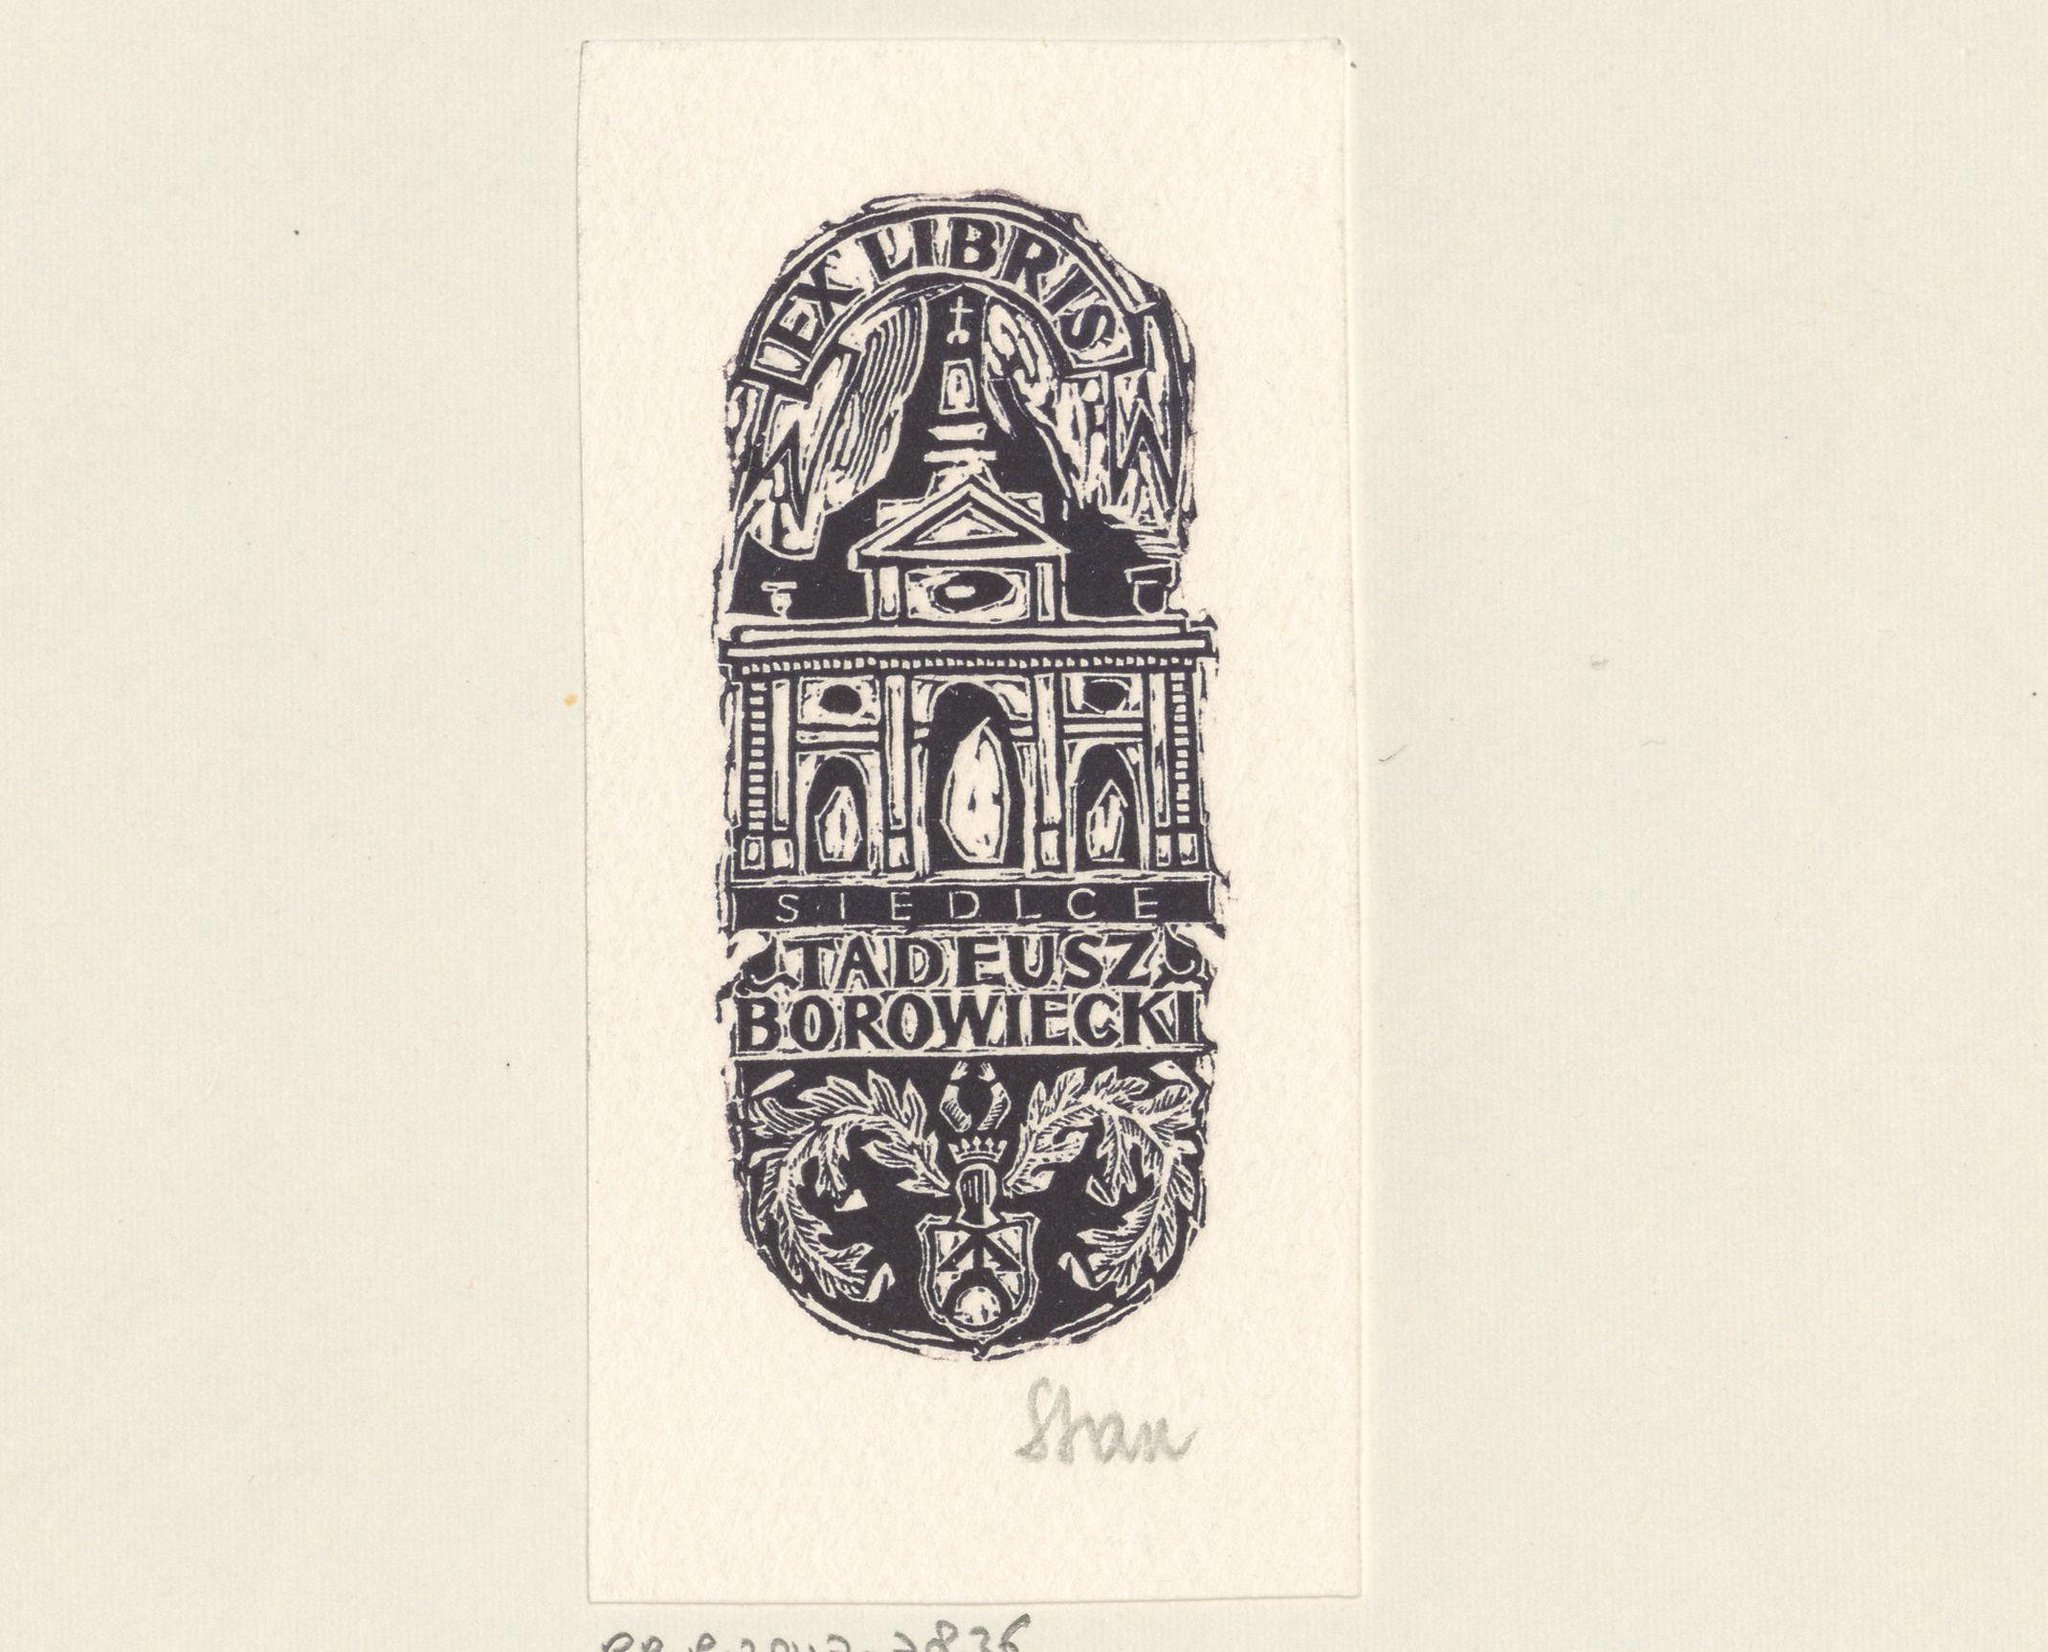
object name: bookplate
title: Ex libris van Tadeusz Borowiecki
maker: stanisłas szymański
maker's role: print maker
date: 1900-1999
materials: paper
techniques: woodcut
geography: poland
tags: church (exterior), armorial bearing, heraldry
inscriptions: signature: ‘Stan’